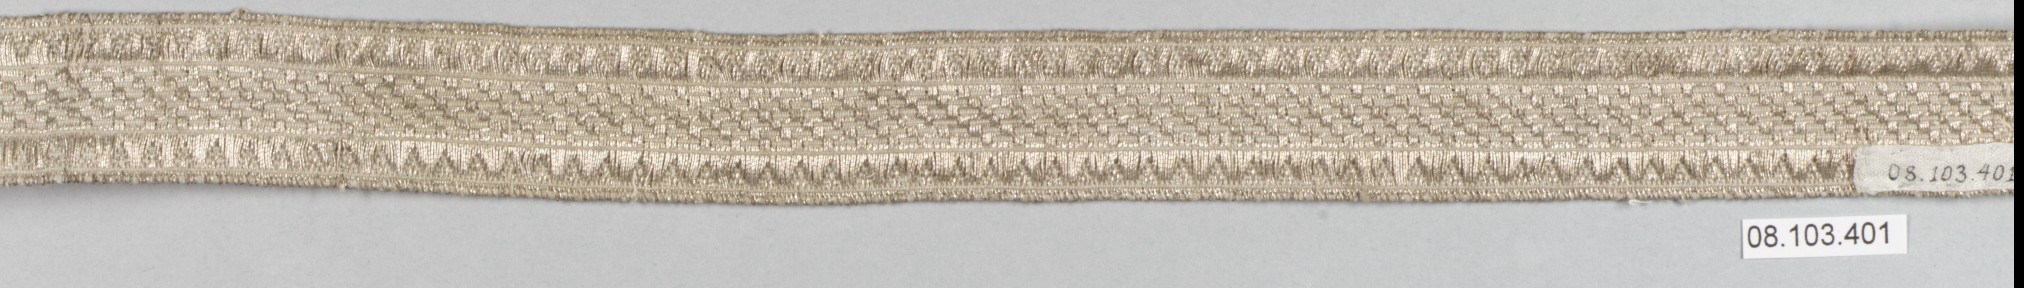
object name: galloon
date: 1701-1900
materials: metal thread